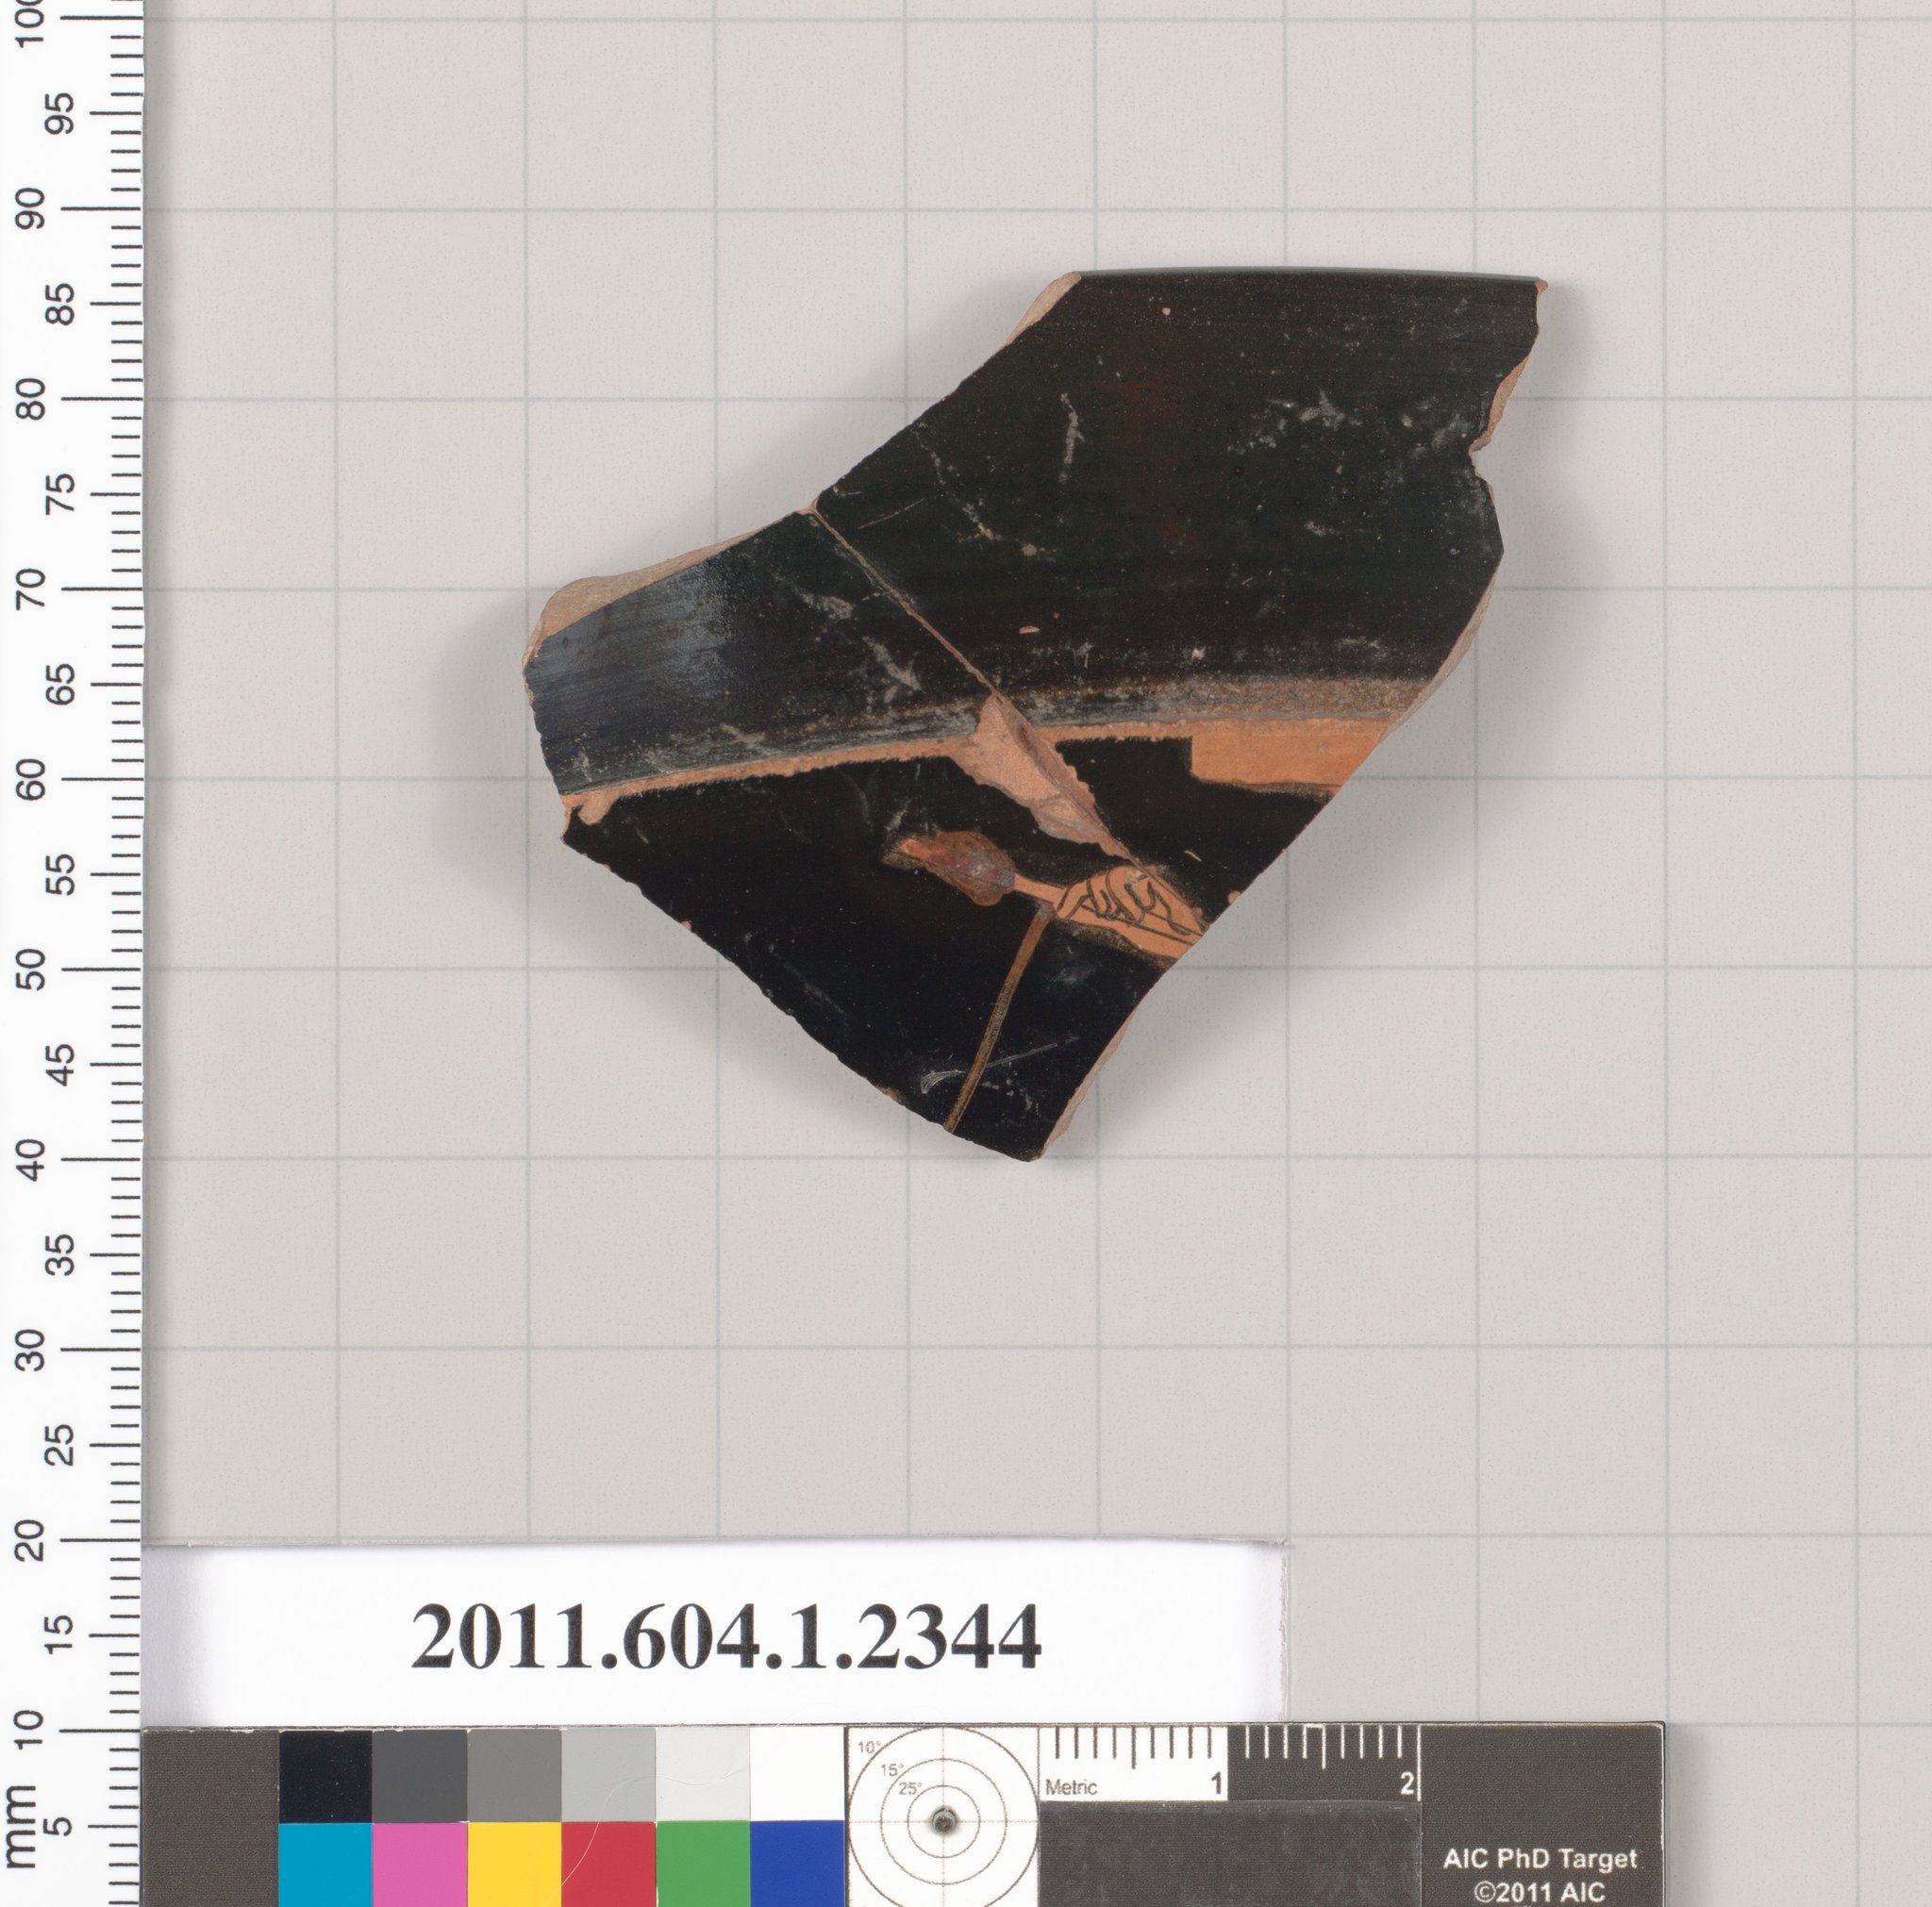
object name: kylix fragment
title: Terracotta rim fragment of a kylix (drinking cup)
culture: greek, attic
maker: telephos painter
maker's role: artist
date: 480-470 BCE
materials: terracotta